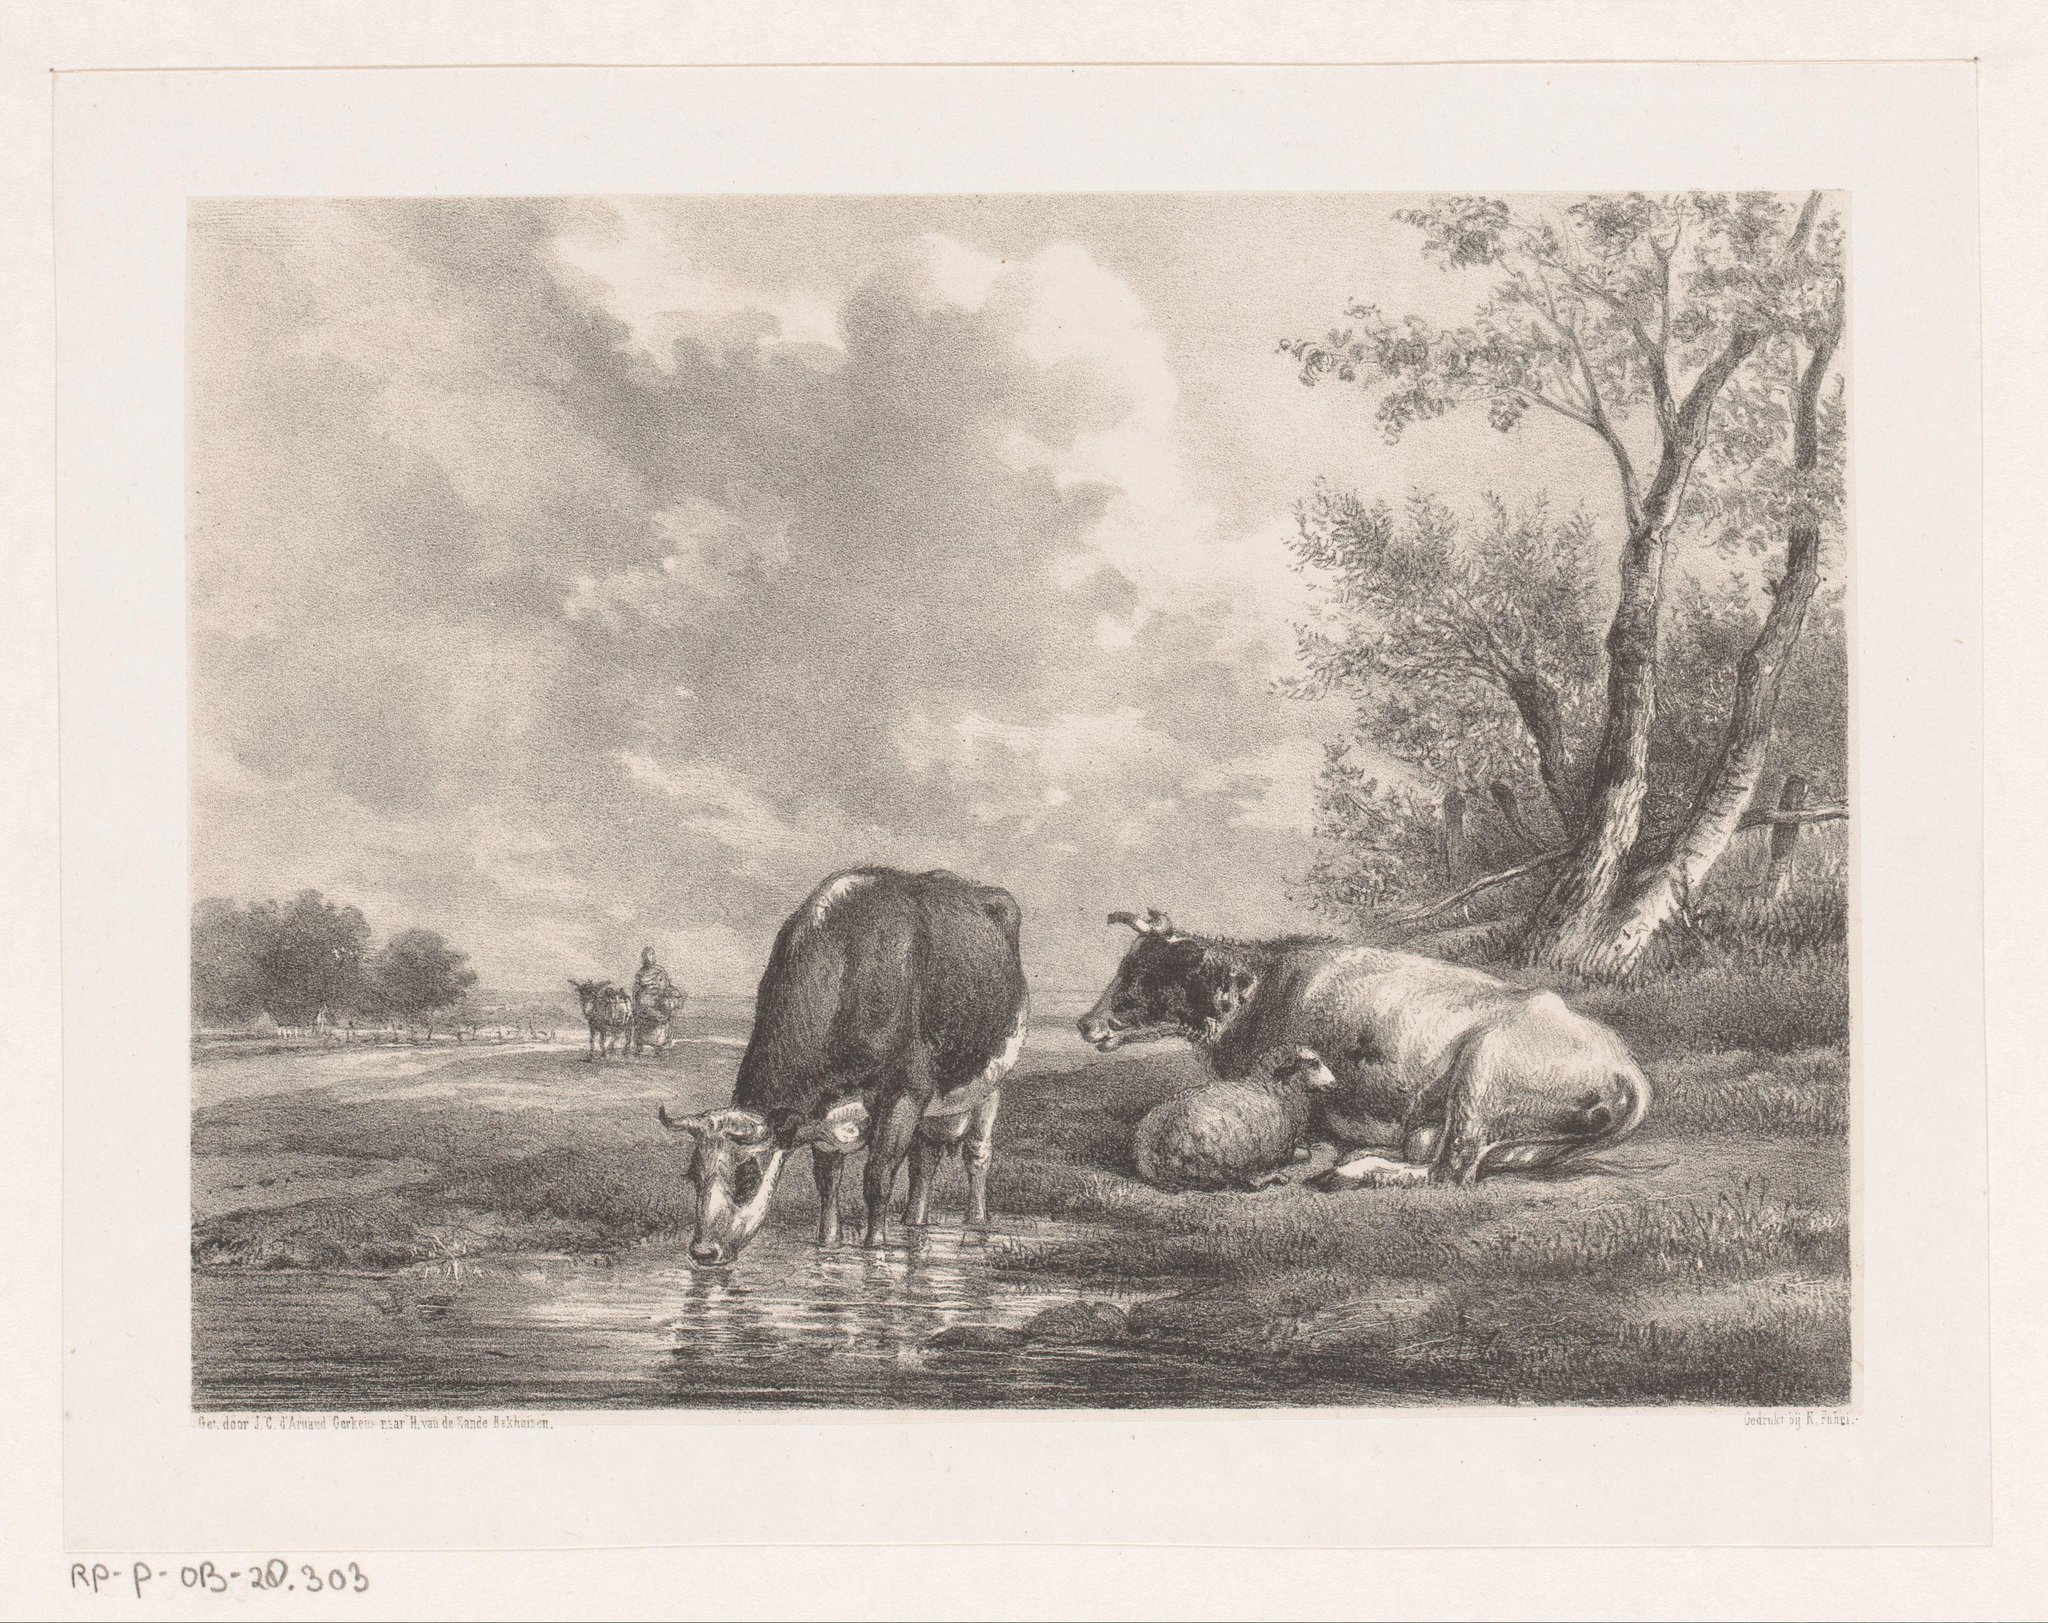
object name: print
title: Twee koeien en schaap bij het water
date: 1837-1853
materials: paper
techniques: lithograph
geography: the hague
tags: ass, donkey, cow (+ animals eating and drinking), meadow, pasture, sheep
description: Een van de koeien drinkt van het water. Verderop loopt een figuur met een ezel.